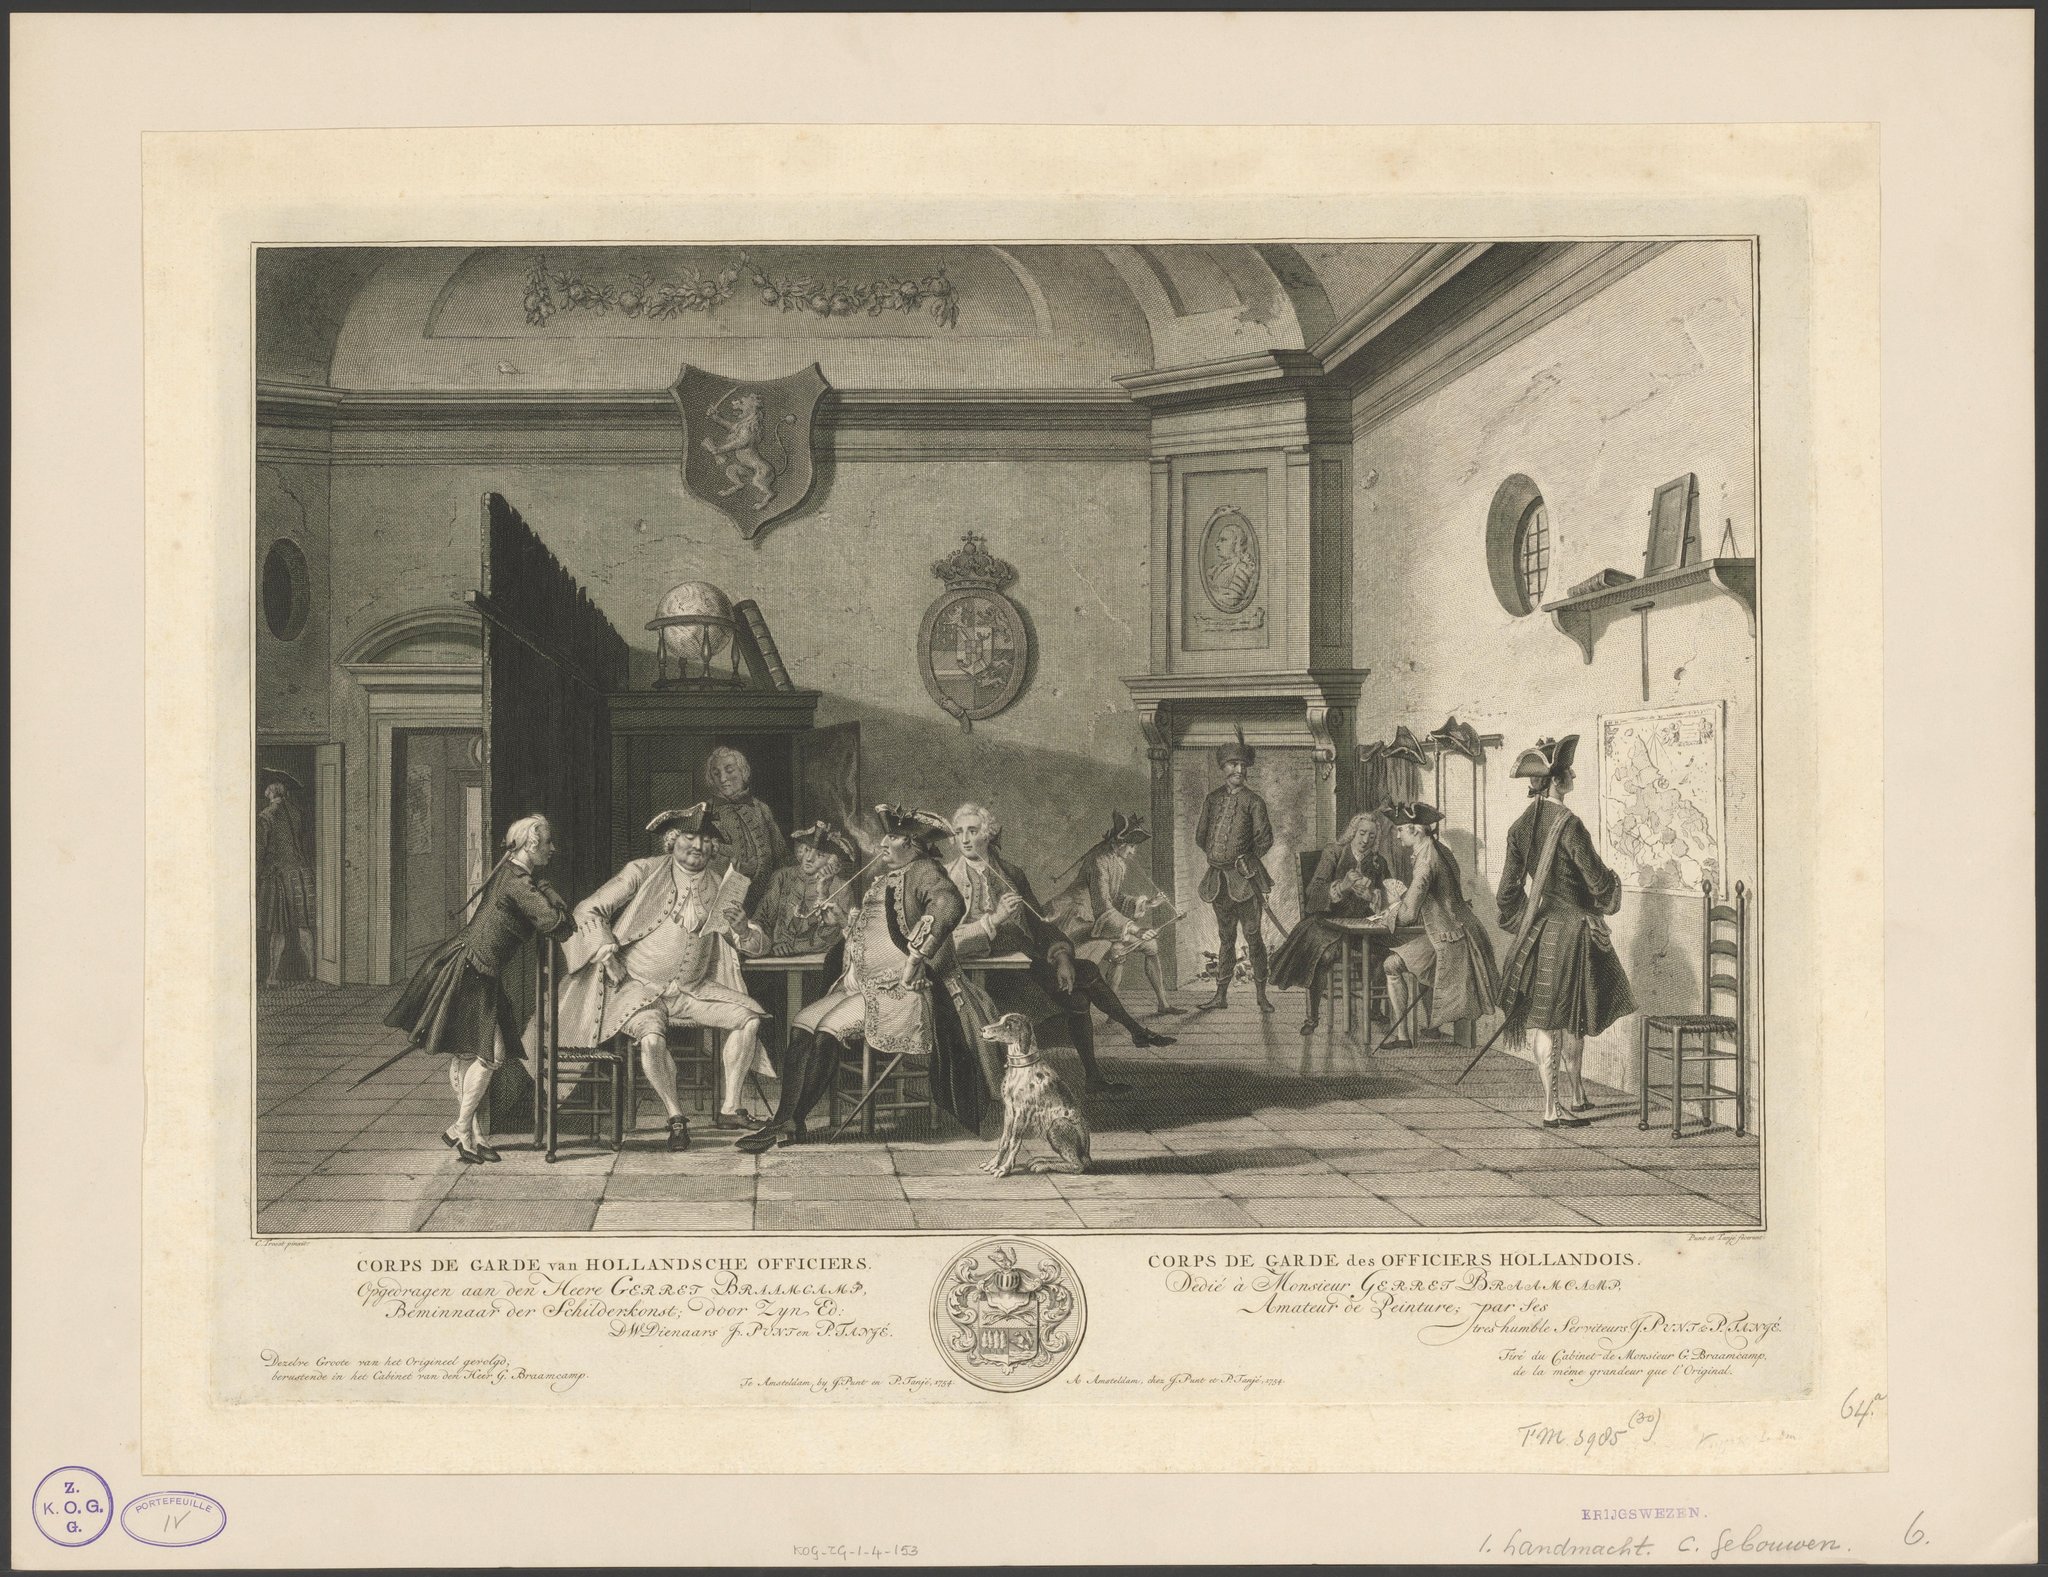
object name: print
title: Corps de Garde van Hollandsche Officiers / Corps de Garde des Officiers Hollandois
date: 1754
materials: paper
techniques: engraving, etching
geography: amsterdam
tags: maps of separate countries or regions, in the guard-room, 'kortegaard', officer, dog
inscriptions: collector's mark: Lugt 1641, collector's mark